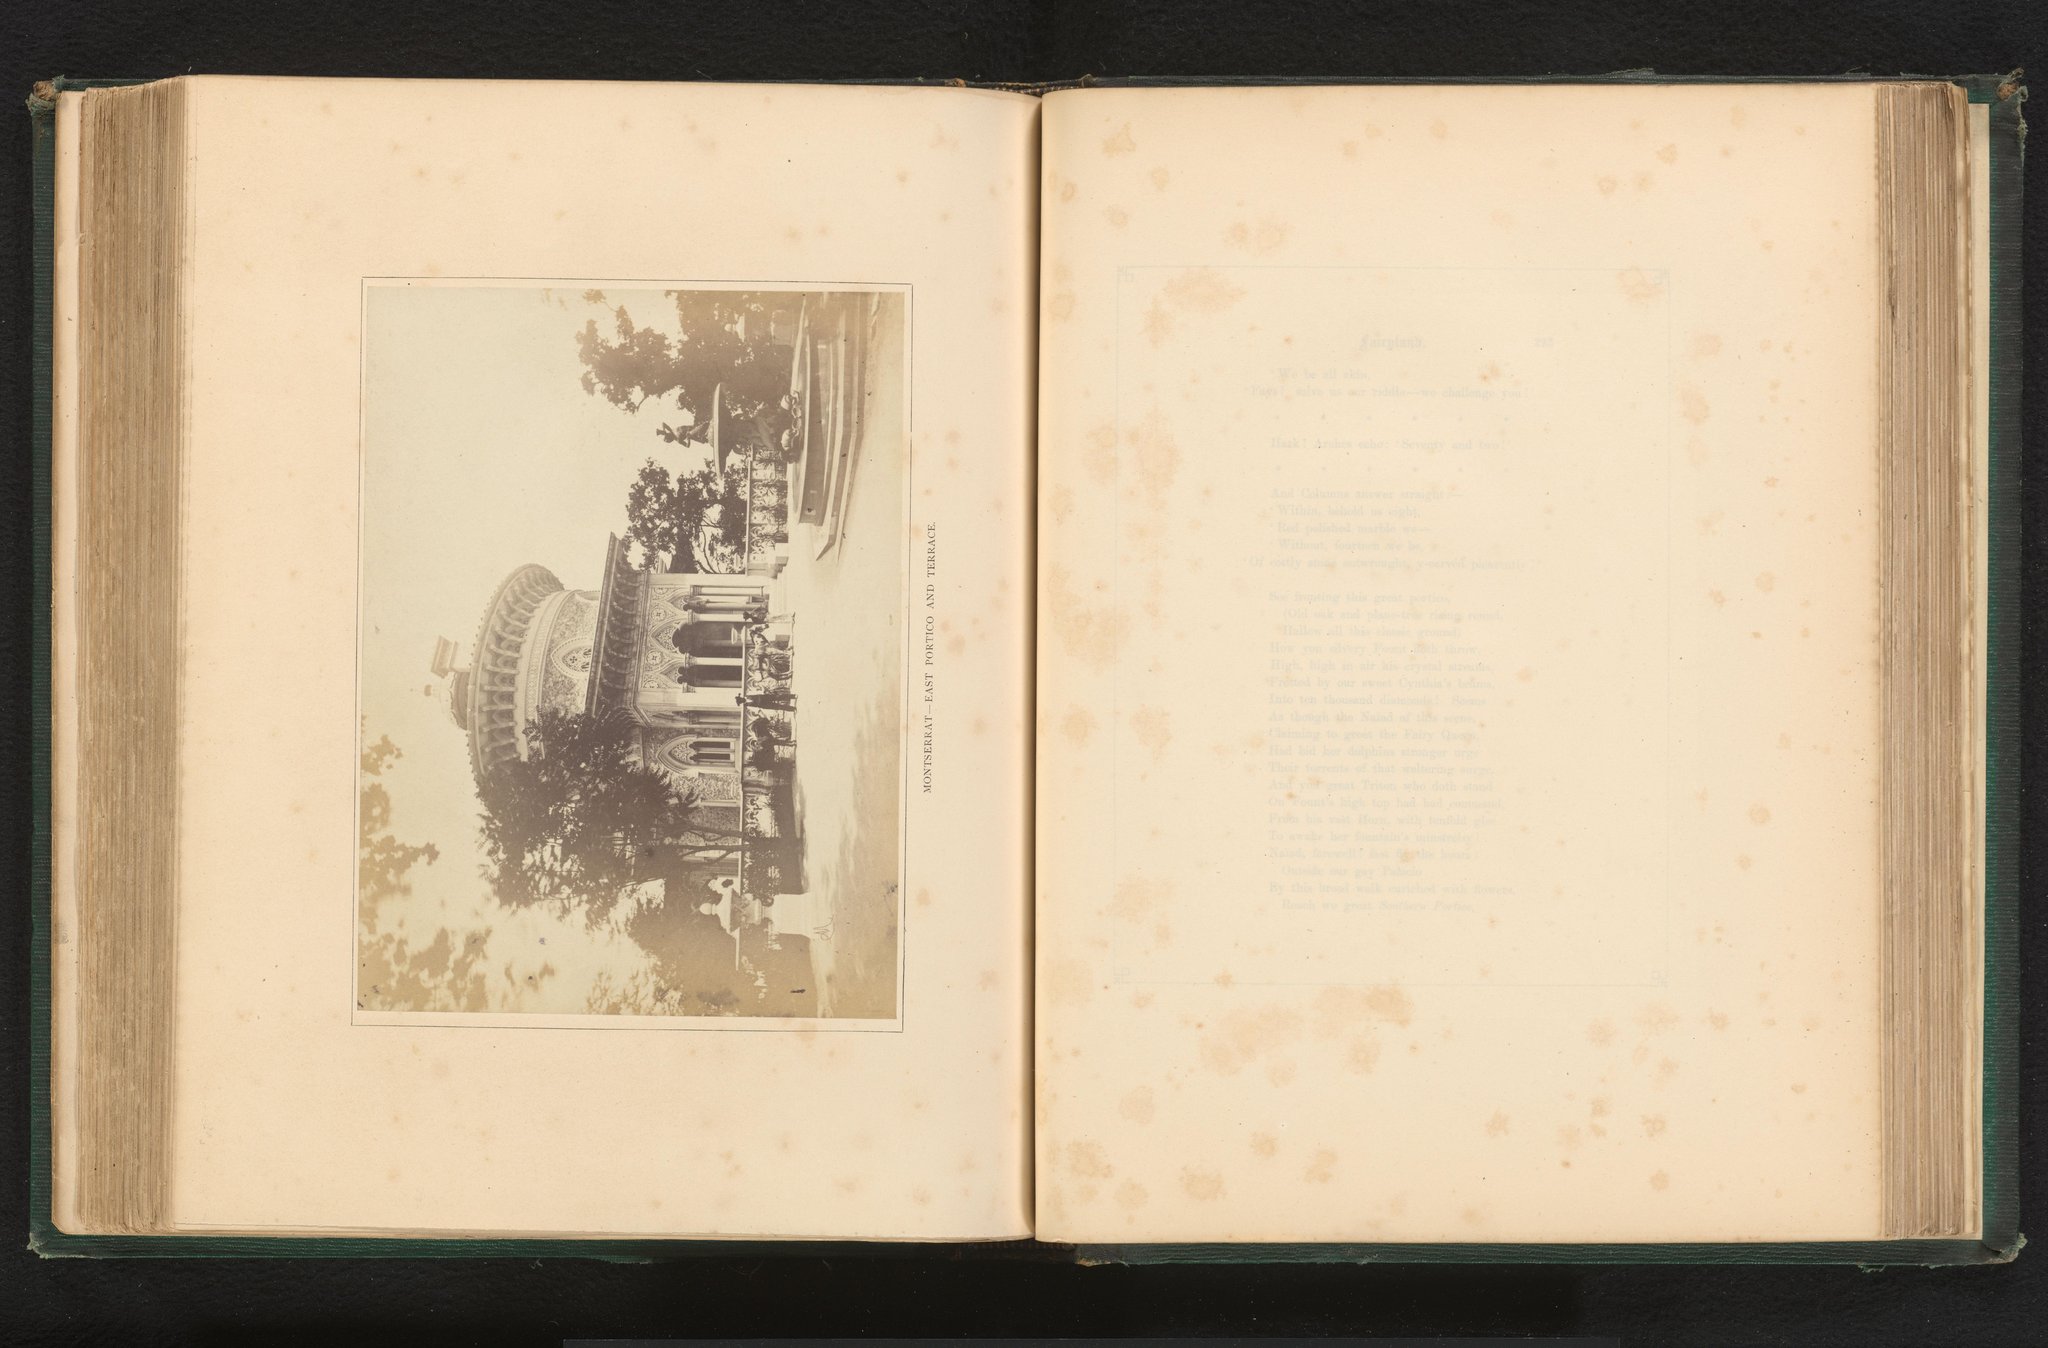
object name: photograph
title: Montserrat - East Portico and Terrace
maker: Anonymous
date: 1865-1870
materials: paper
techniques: albumen print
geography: sintra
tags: palace, gate, entrance, terrace